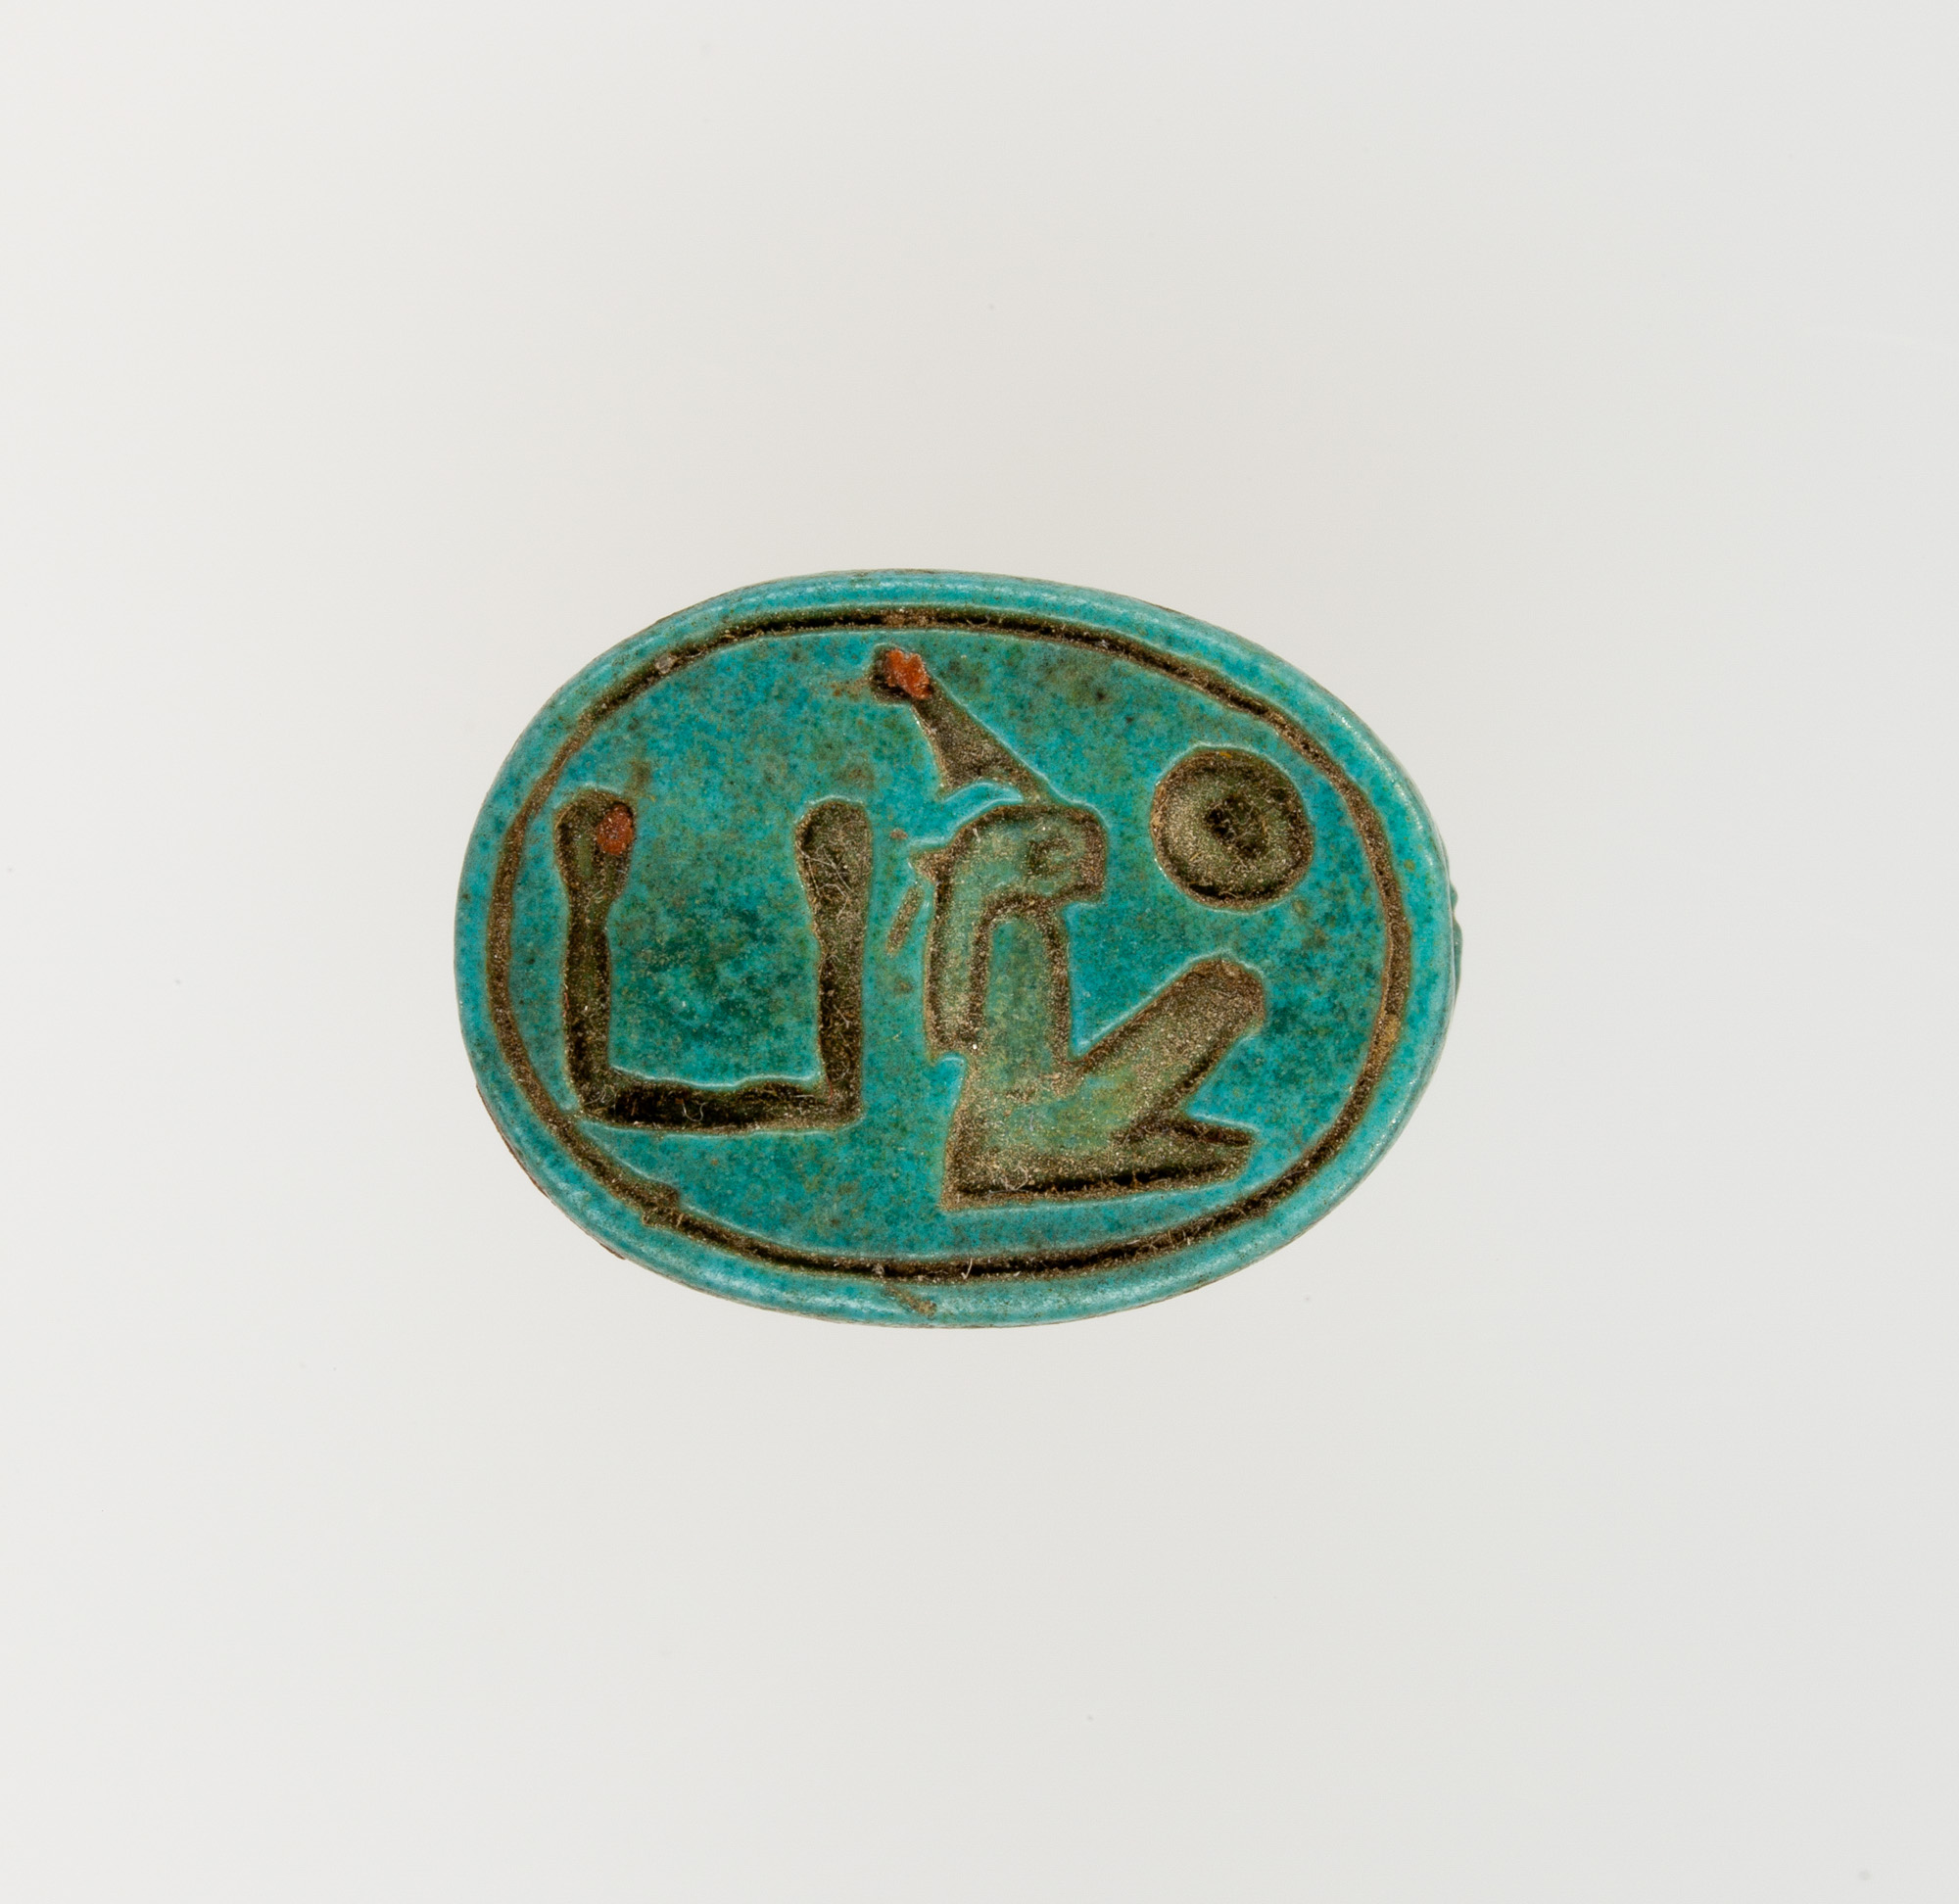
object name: scarab, maatkare hatshepsut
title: Scarab Inscribed with the Throne Name of Hatshepsut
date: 1479-1458 BCE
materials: stone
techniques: glazing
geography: egypt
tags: hieroglyphs,scarabs